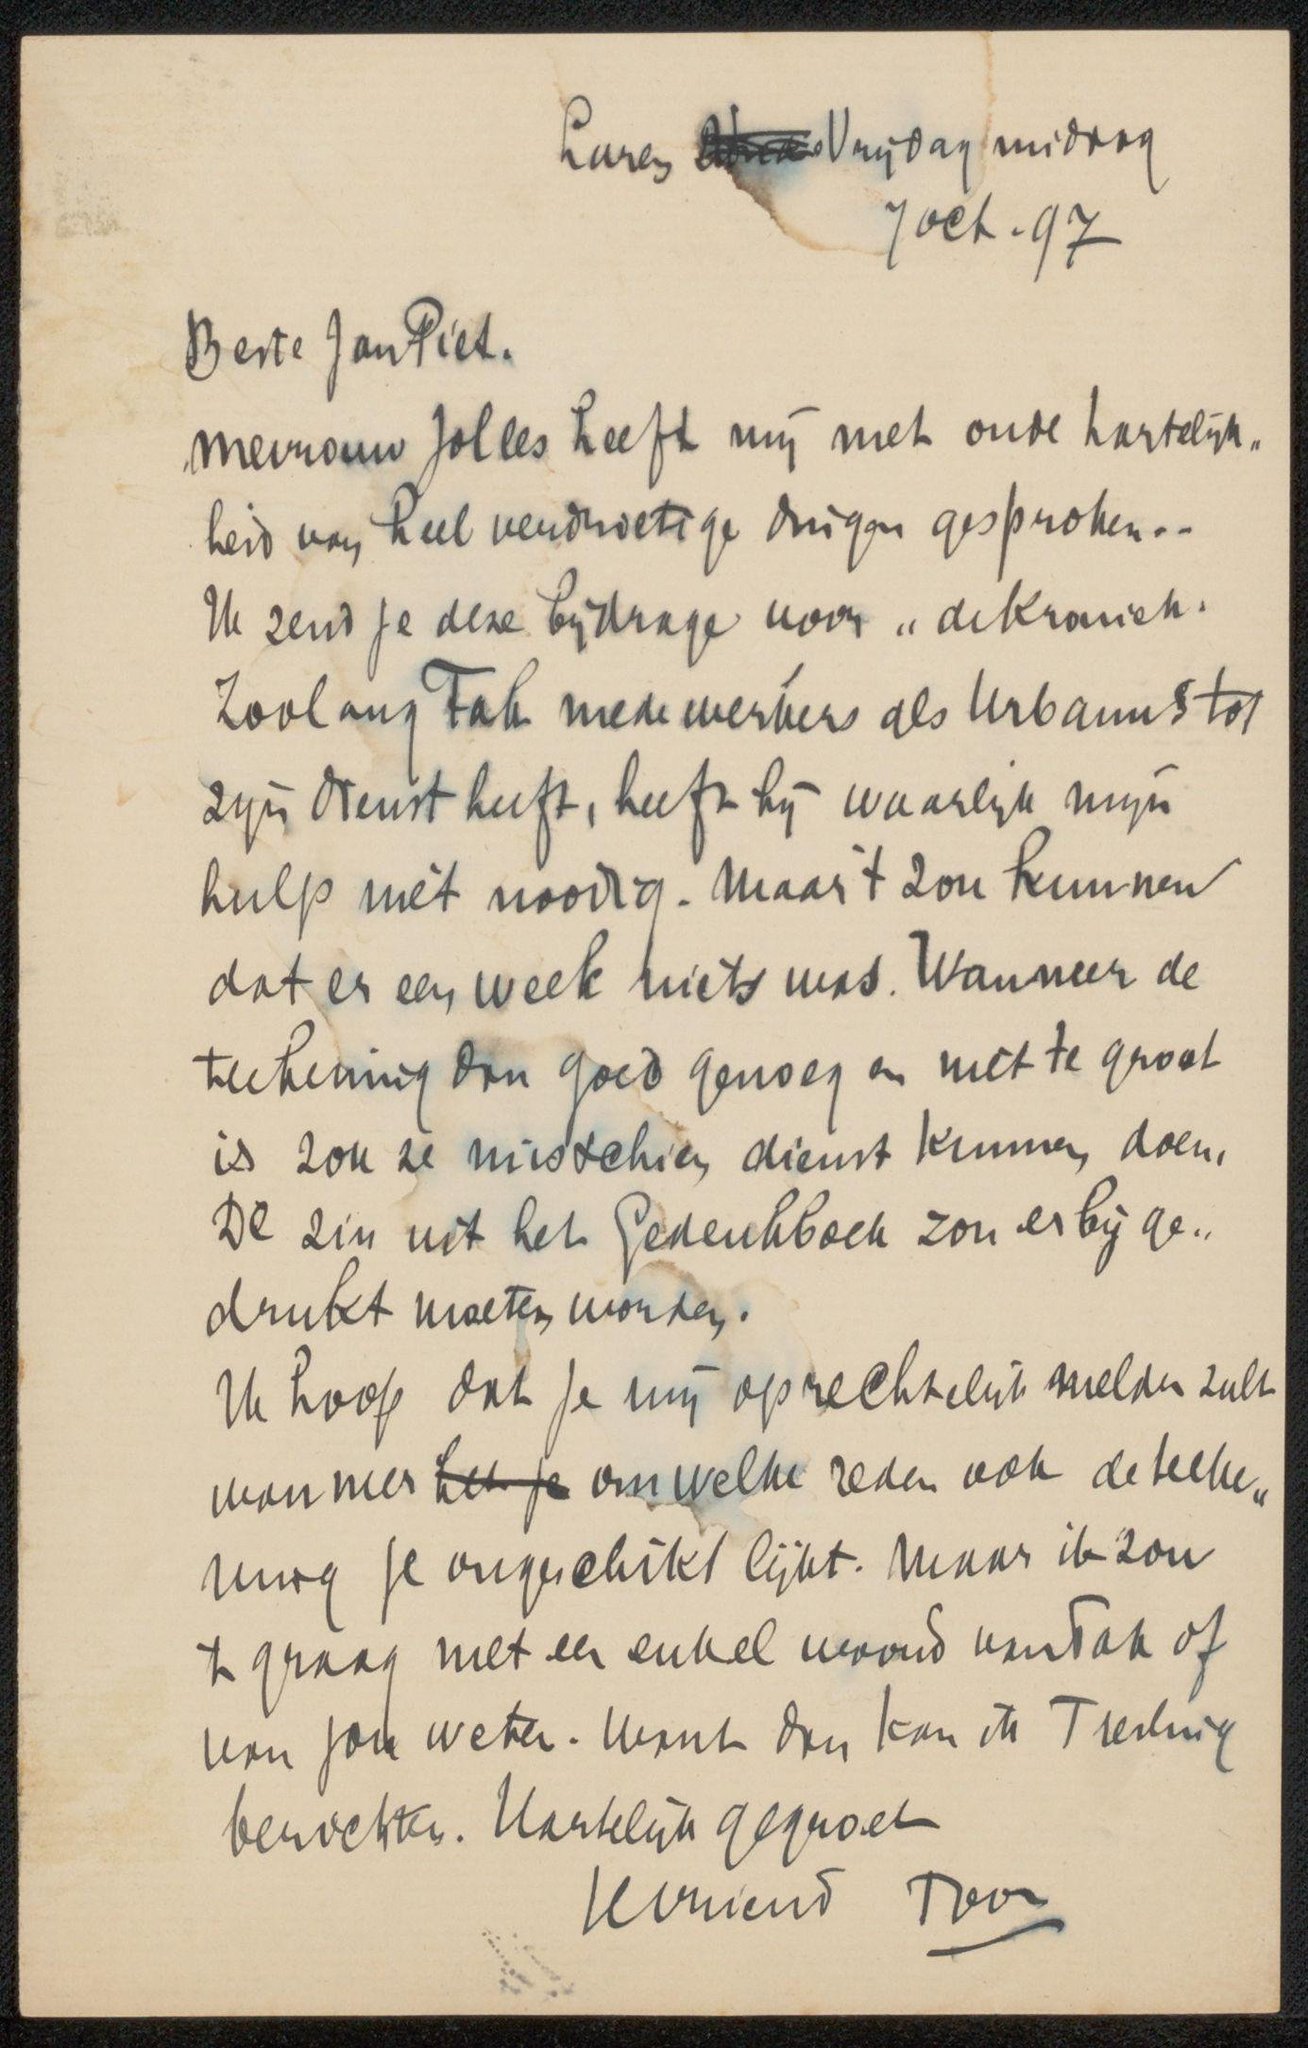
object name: letter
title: Brief aan Jan Veth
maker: antoon derkinderen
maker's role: draughtsman, painter, print maker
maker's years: 1859-1925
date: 1897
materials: ink, paper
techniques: pen, writing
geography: laren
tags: jan veth, politician, pieter lodewijk tak, amsterdam, jacoba cornelia jolles-singels, drawing, printed matter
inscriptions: collector's mark: ‘RPK’